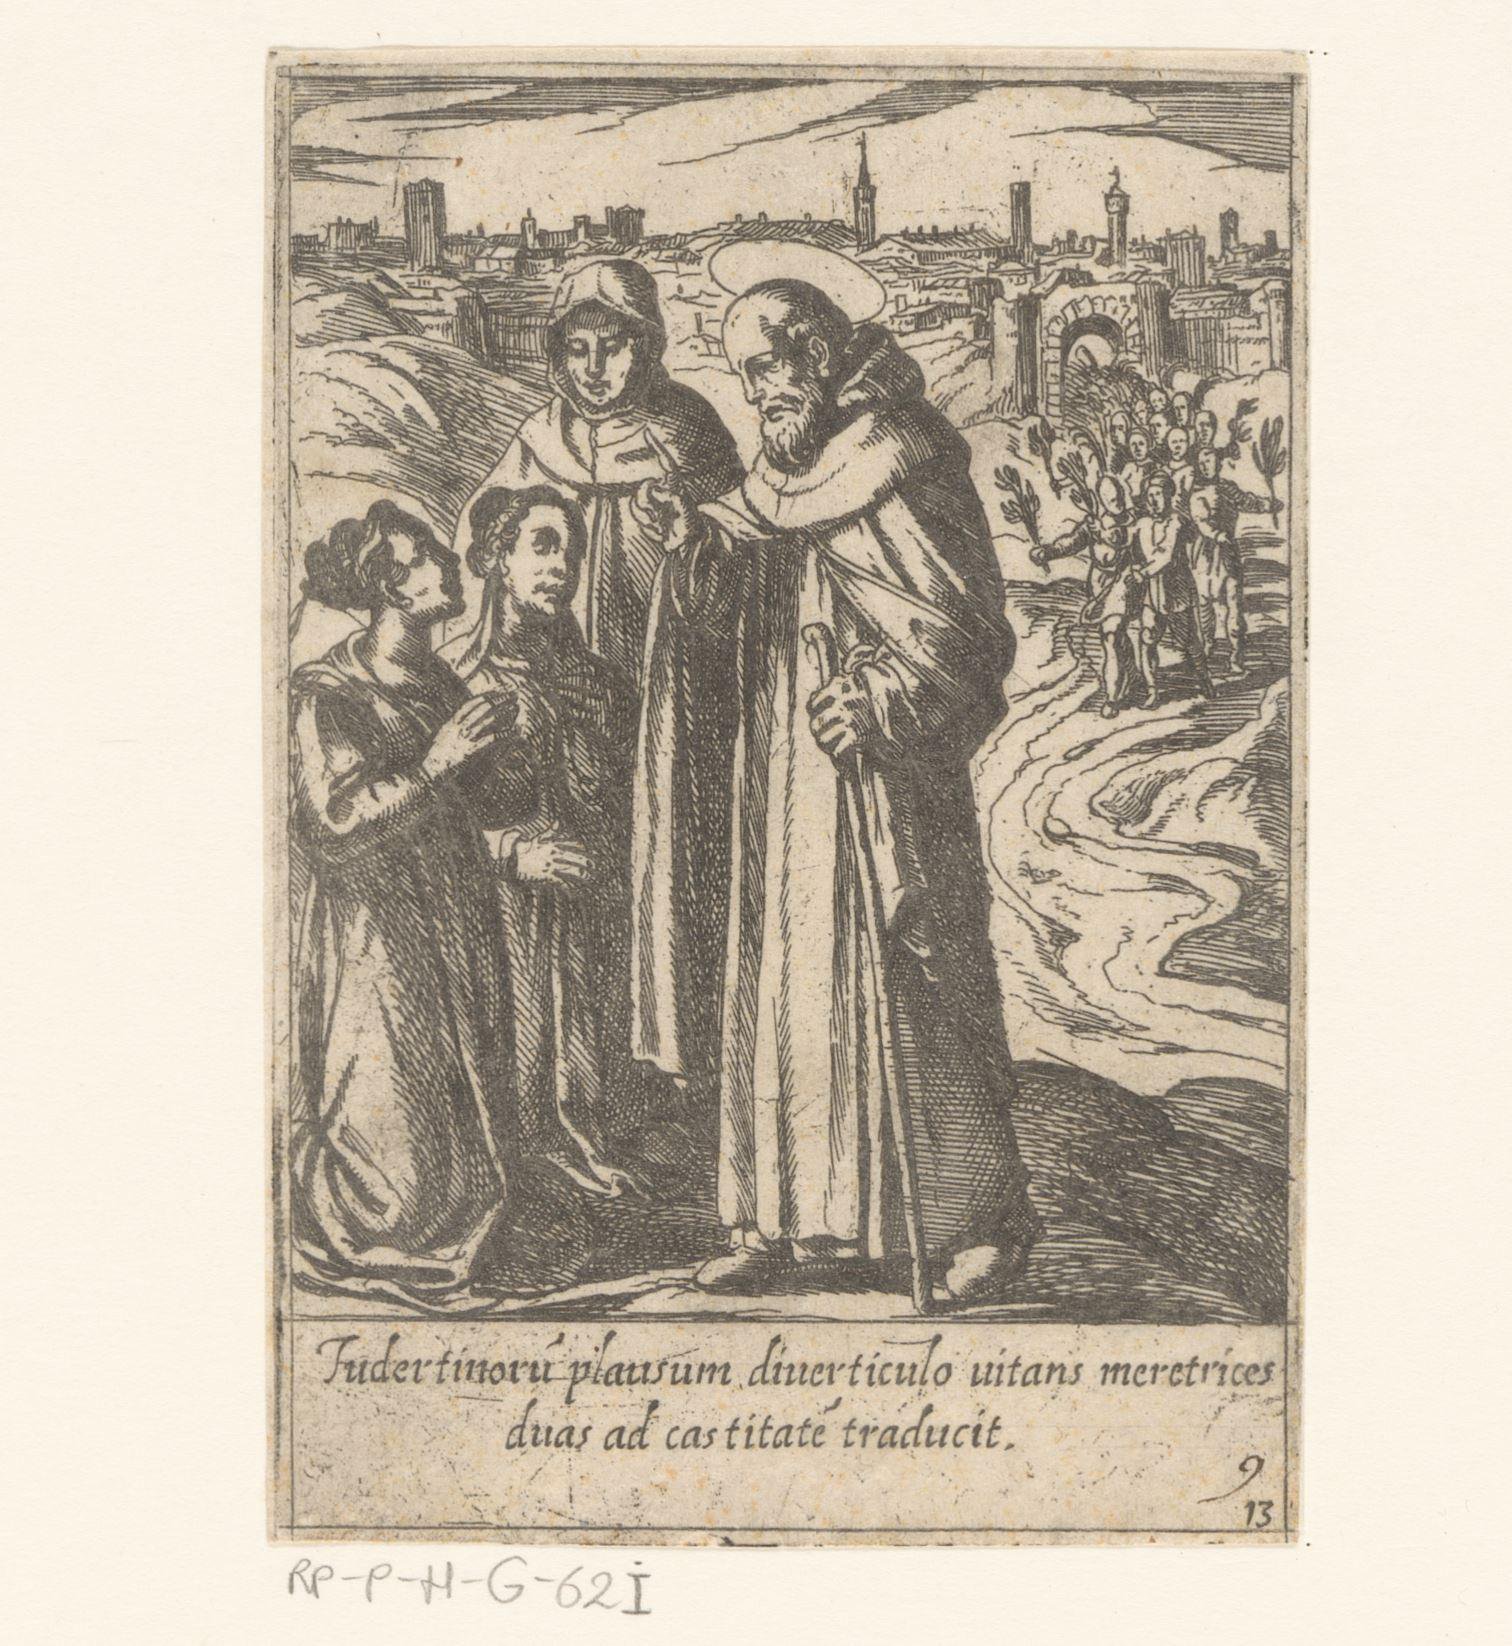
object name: print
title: Het Leven van Philippus Benitius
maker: antonio tempesta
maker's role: draughtsman, painter, print maker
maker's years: 1555-1630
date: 1591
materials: paper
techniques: etching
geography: rome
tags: clergyman, prior general of the order of the servites, philip benizzi of florence; possible attributes: book, cross, lily, tiara at his feet, whore, prostitute, prostitution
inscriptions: collector's mark: ‘Hinloopen’, number: ‘9’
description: De heilige Philippus bekeert twee prostituees tot kuisheid. Op de achtergrond een stadsgezicht. Tekst in het Latijn in ondermarge. Genummerd rechtsonder: 13.